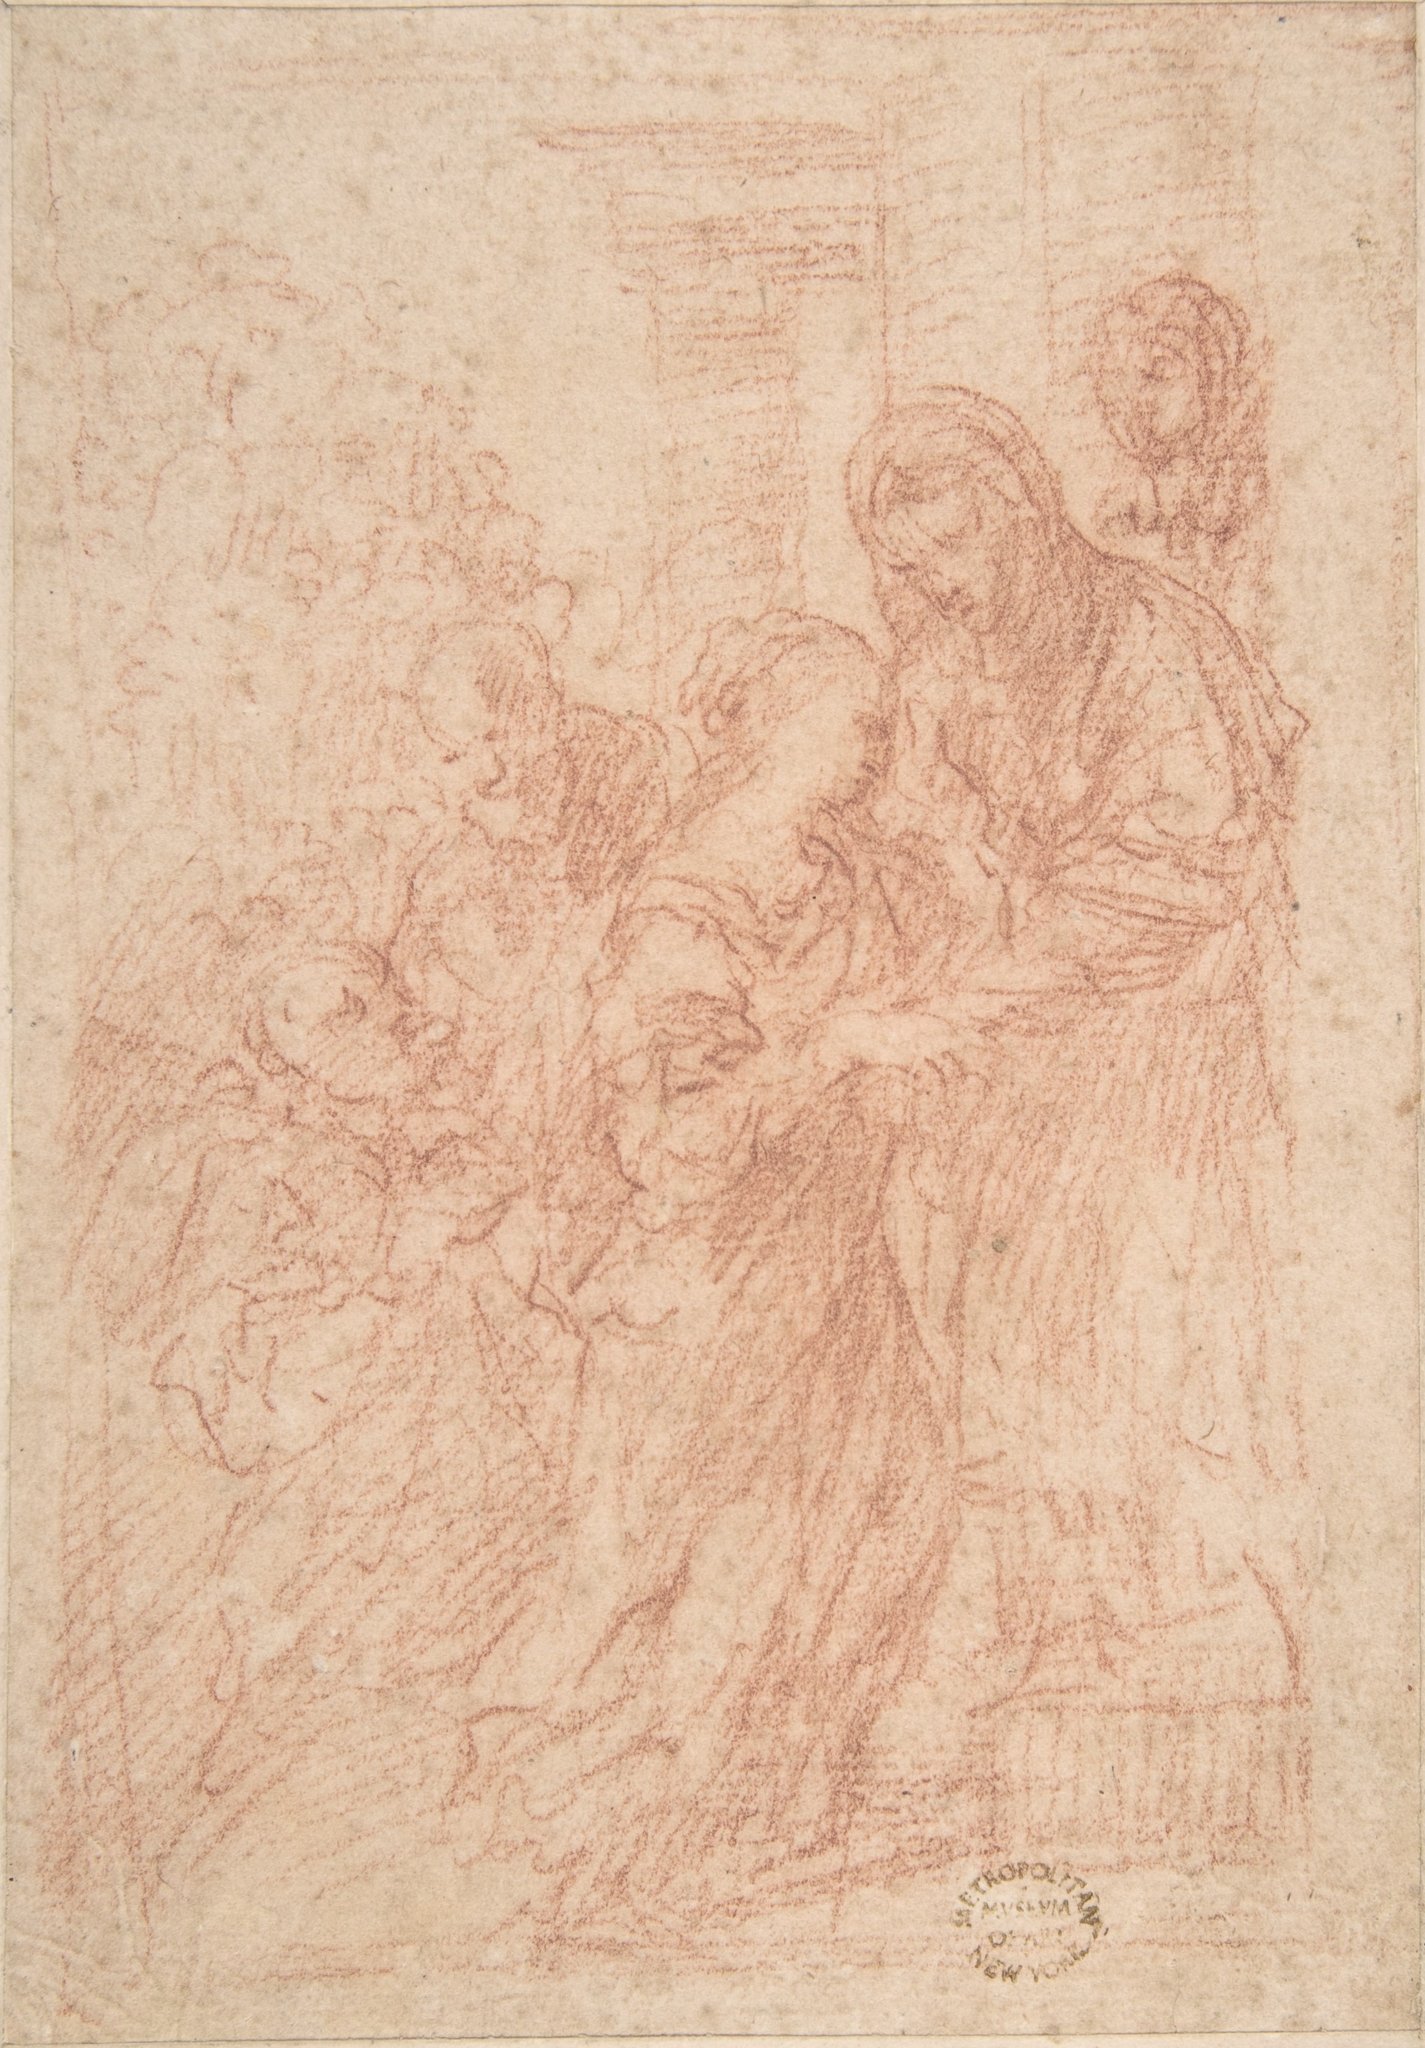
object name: drawing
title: The Visitation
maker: anonymous, italian, roman-bolognese, 17th century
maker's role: artist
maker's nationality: italian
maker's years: 1600-1700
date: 1601-1700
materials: chalk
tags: women,virgin mary